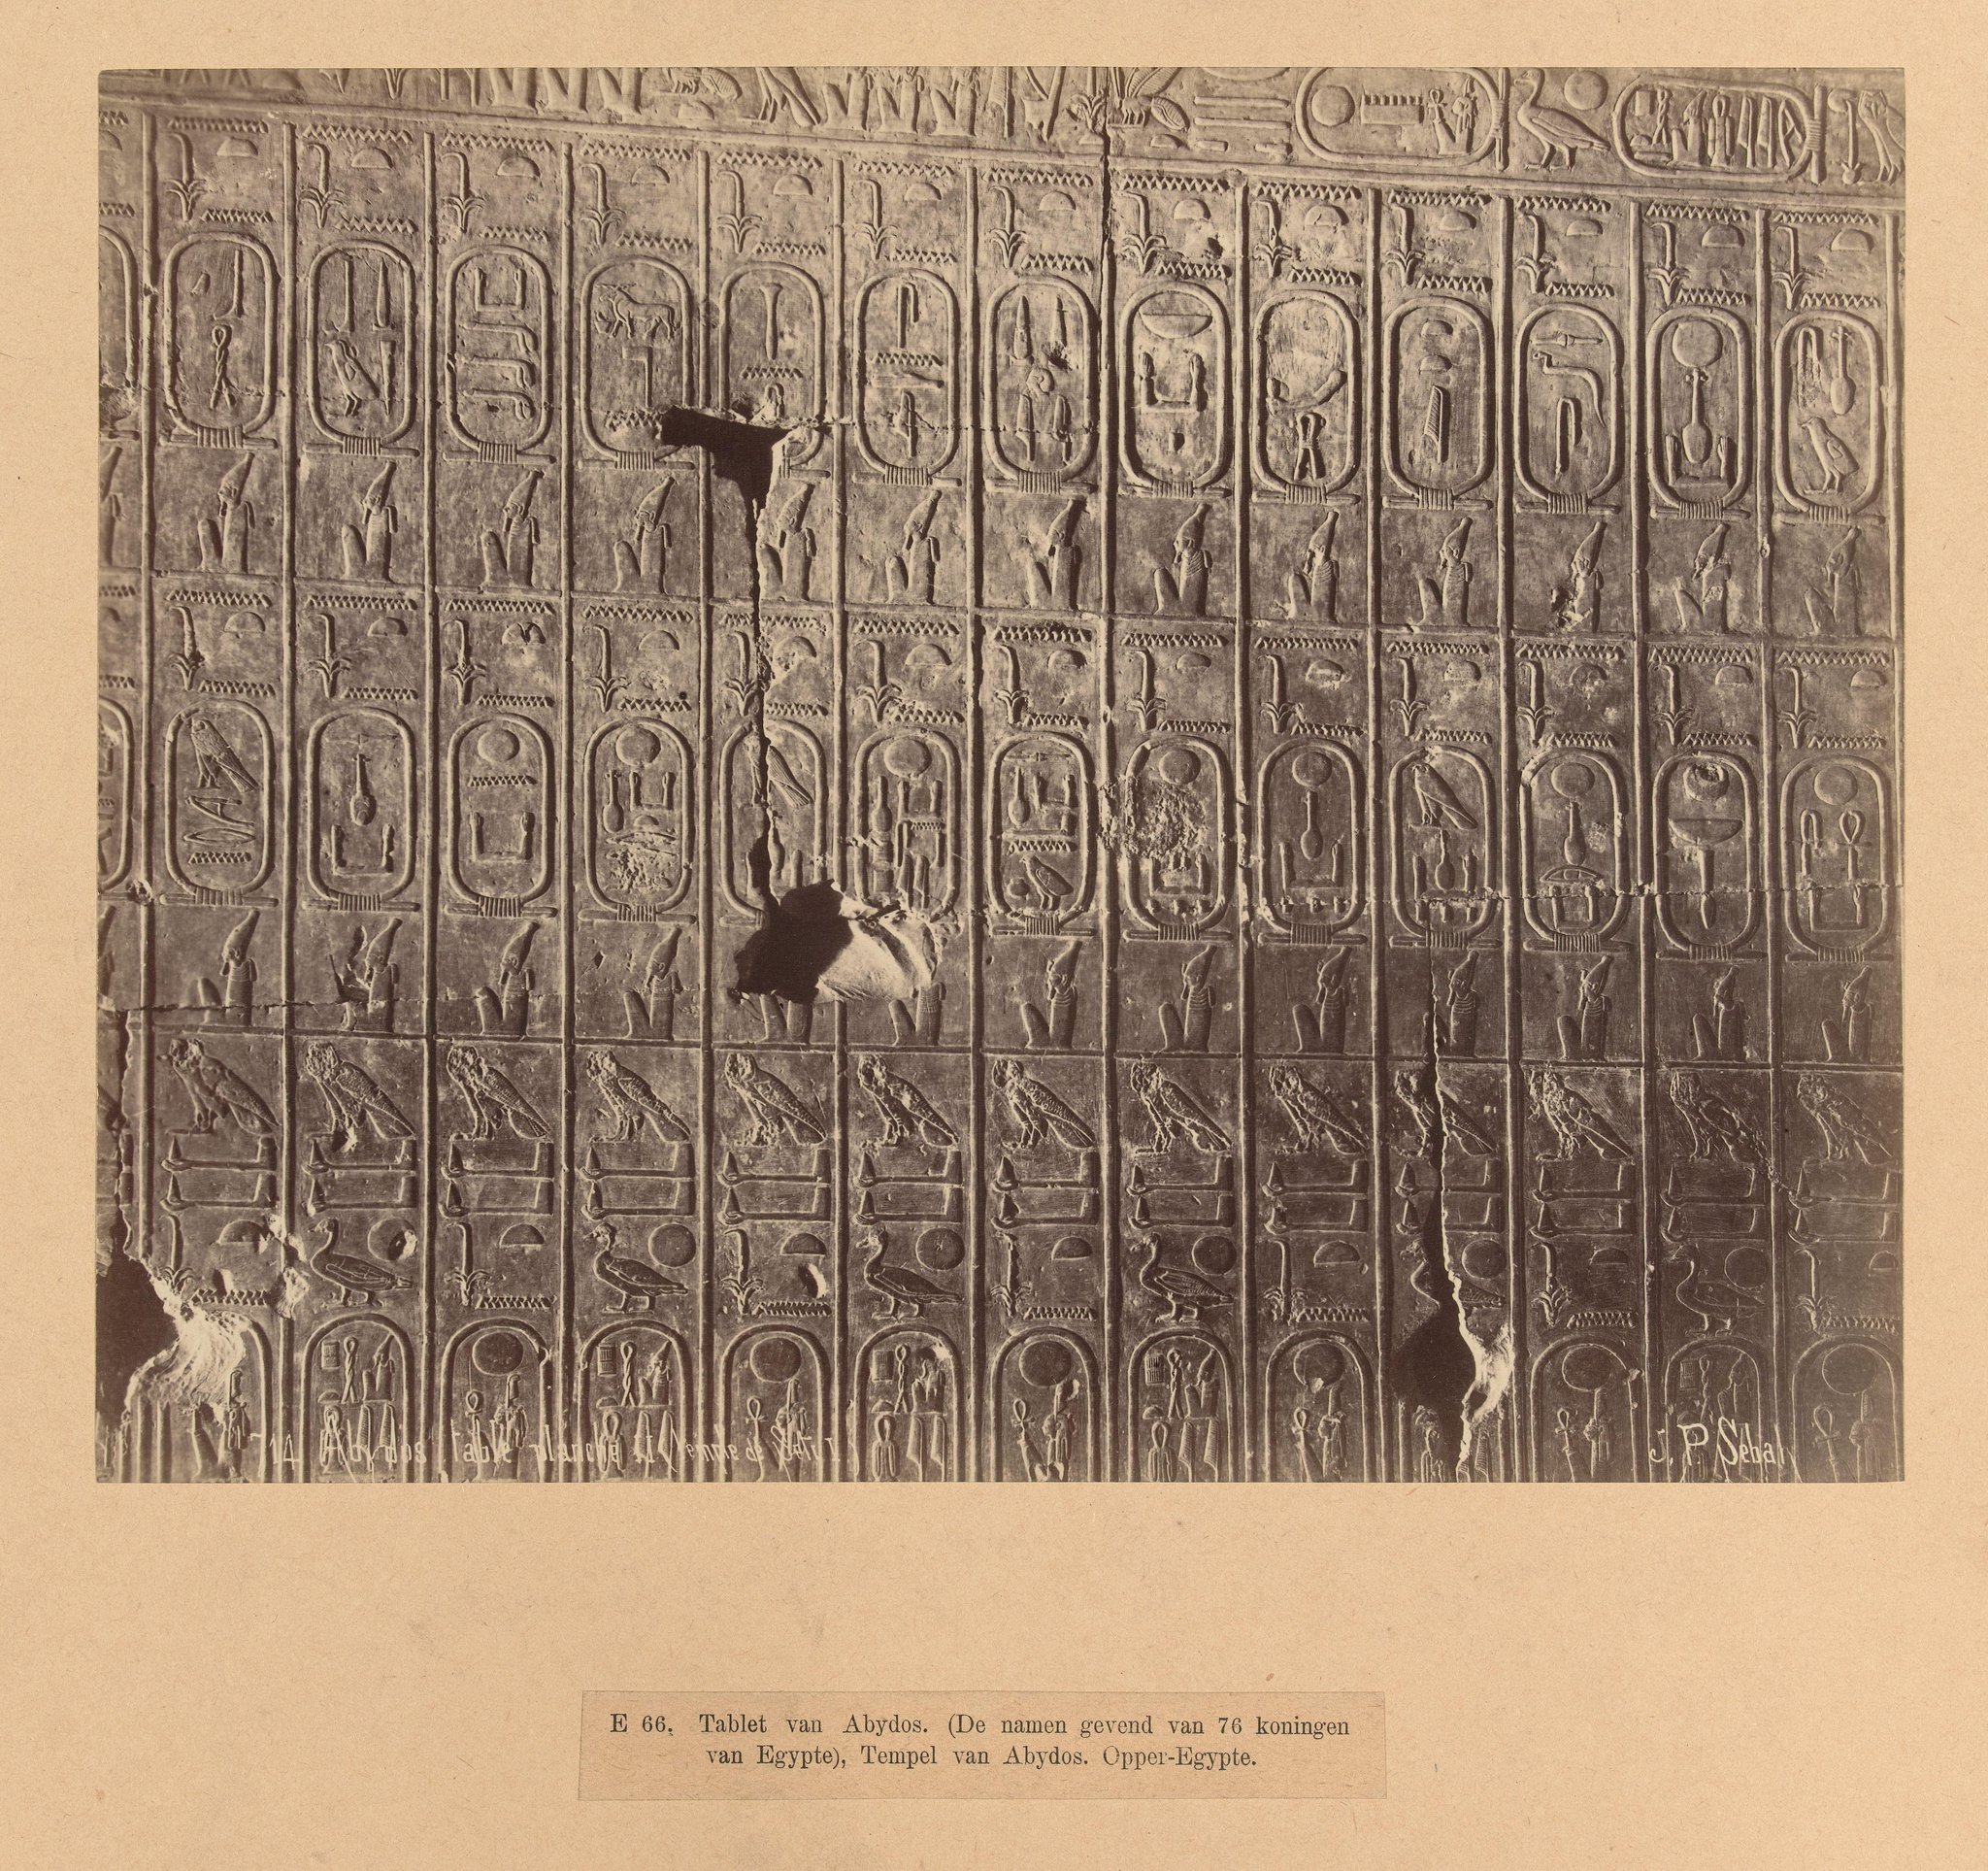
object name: photograph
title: Groep van 61 foto's van Egypte en Syrië verzameld door Richard Polak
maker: richard polak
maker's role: fotograaf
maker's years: 1870-1957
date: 1860-1910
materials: paper, cardboard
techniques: albumen print, gelatin silver print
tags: syrië, egypte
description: Groep van 61 foto's van Egypte en Syrië verzameld door fotograaf Richard Polak. Het merendeel van deze foto's is samen met andere op zijn reizen verzamelde foto's tentoongesteld bij de Rotterdamsche Kunstkring (1895), Arti en Amicitiae te Amsterdam (1897-1898?) en Societeit 't Collegie te Kampen (datum vooralsnog onbekend). Elf foto’s (RP-P-1997-28-51 t/m RP-P-1997-31-60), op een latere reis gemaakt door Polaks reisgenoot mr. L. de Bruyn, zijn later aan de verzameling toegevoegd.